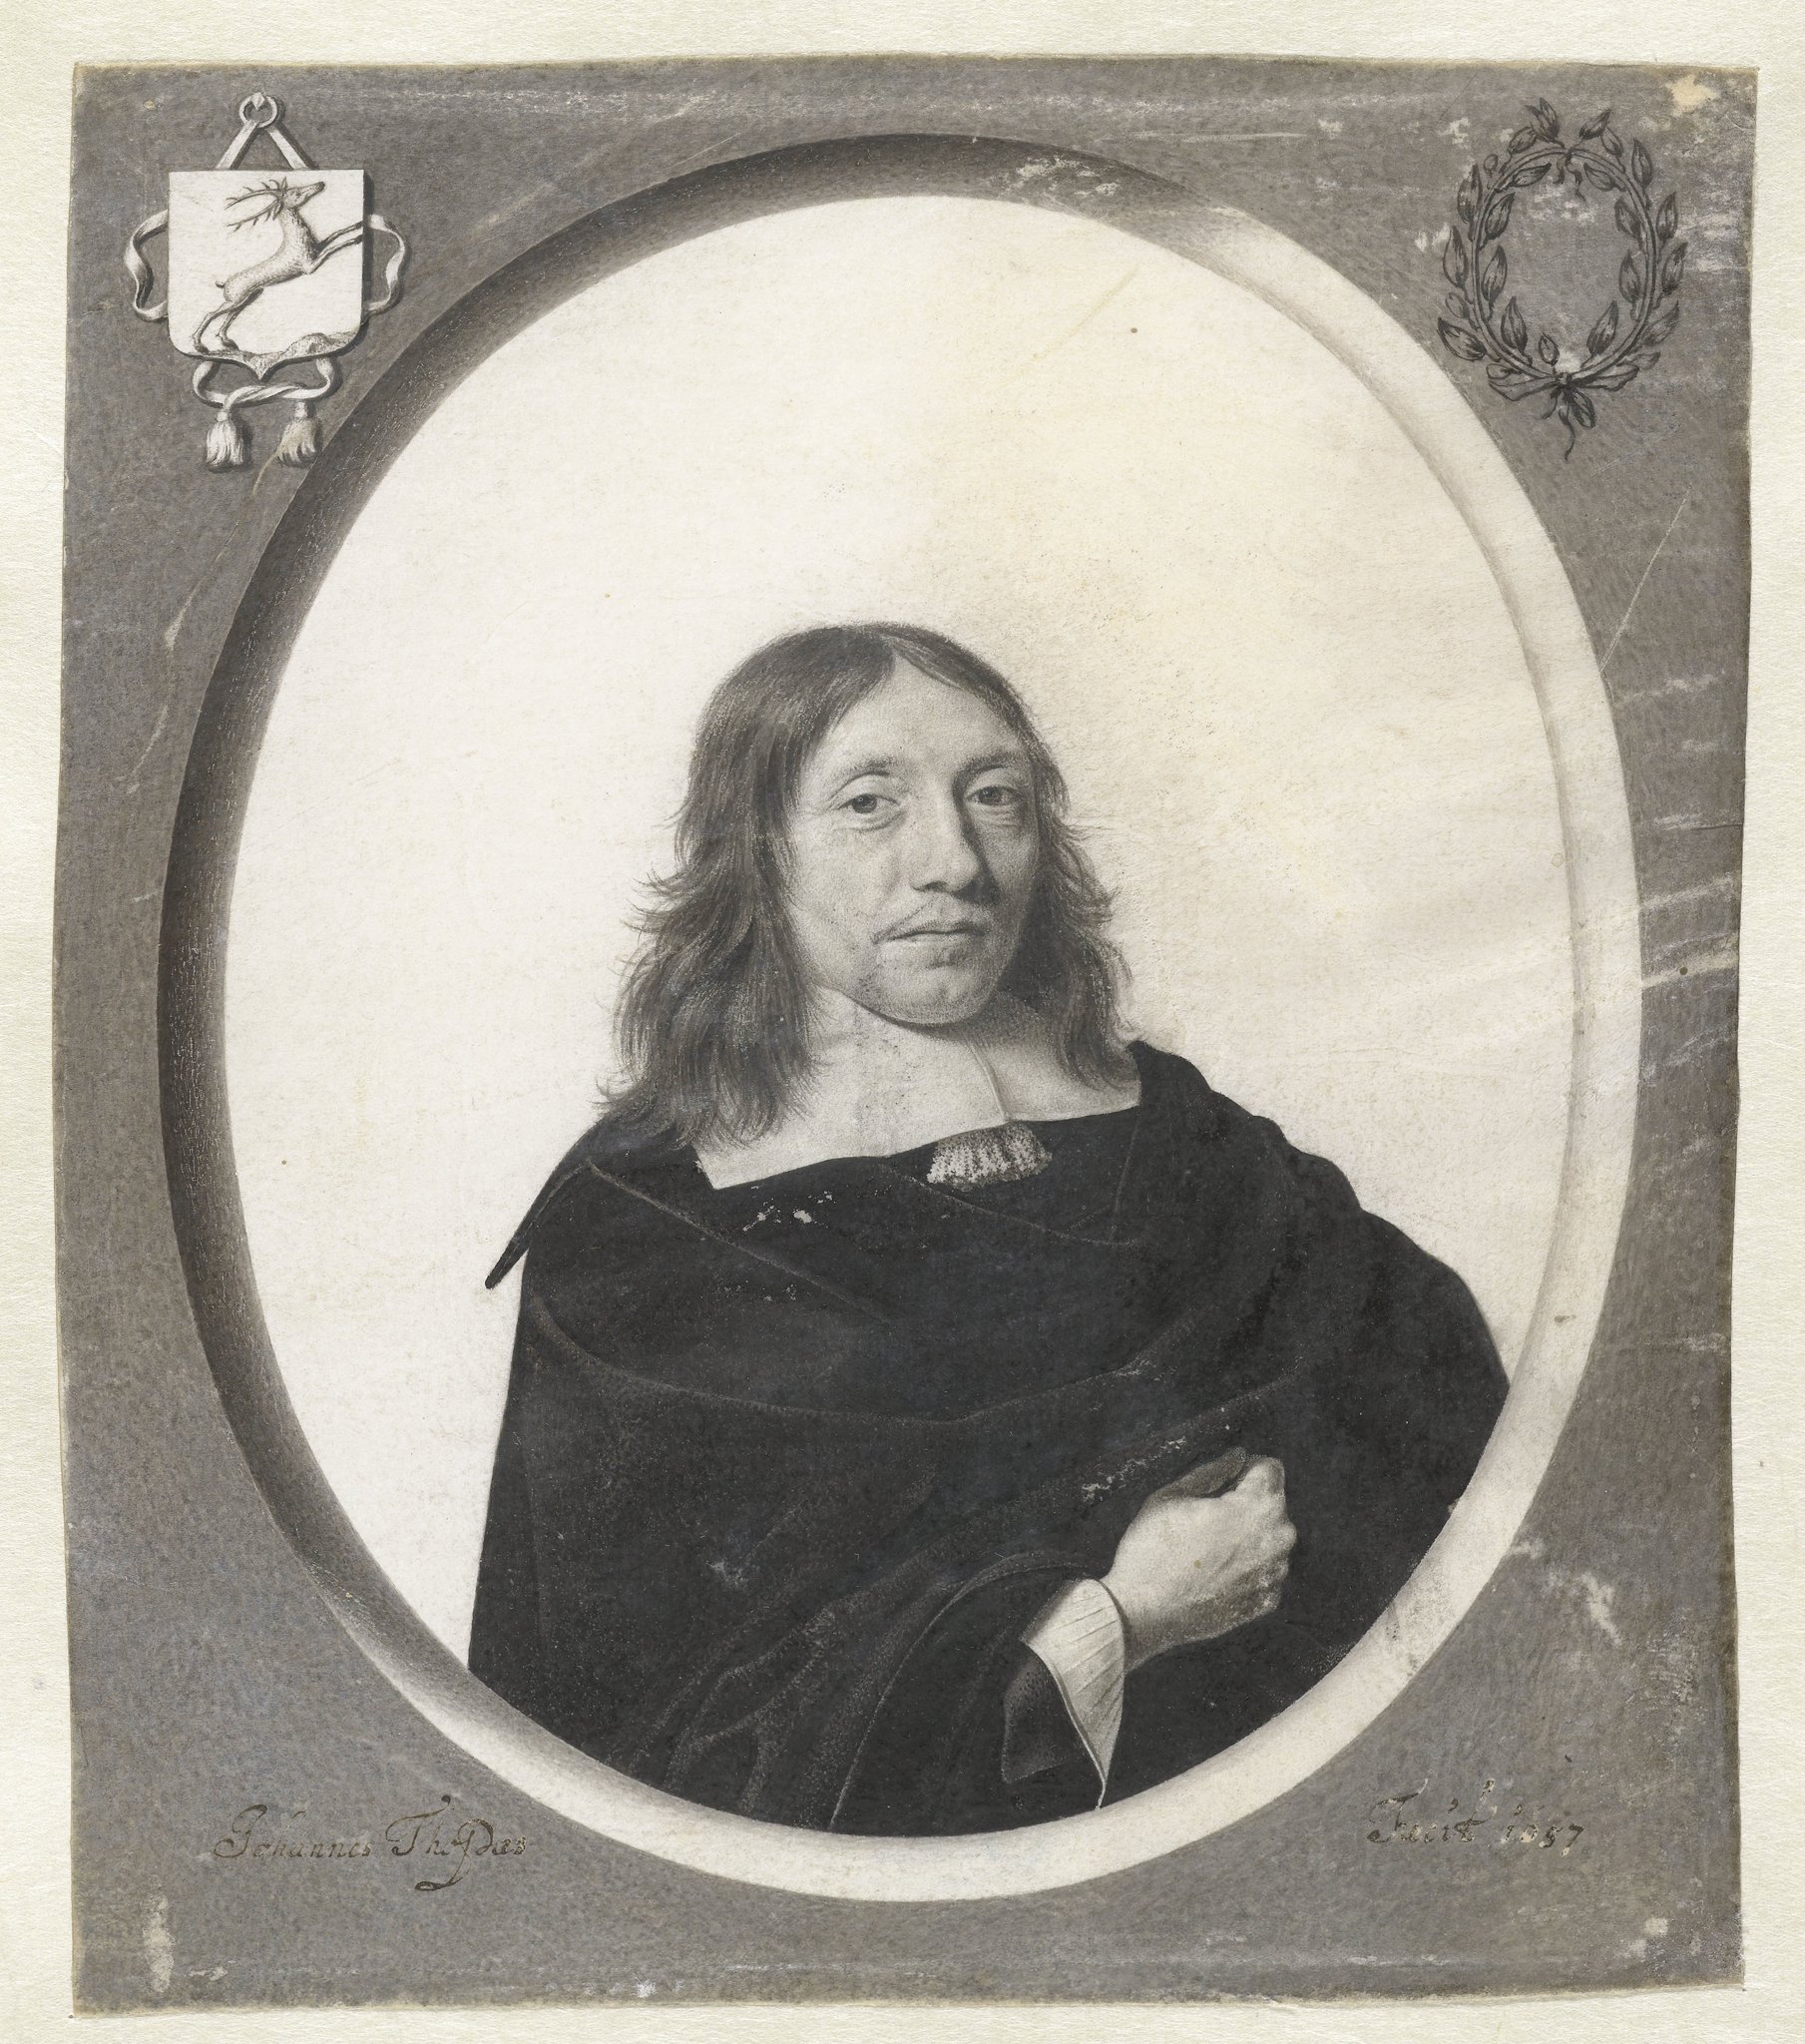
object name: drawing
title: Portrait of Gijsbert van der Hoeven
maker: jan thopas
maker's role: draughtsman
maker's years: 1630-1700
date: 1657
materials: graphite, ink, parchment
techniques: brush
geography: amsterdam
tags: anonymous historical person portrayed alone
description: Portret van Gijsbert van der Hoeven; links een wapenschild, rechts een lauwerkrans.